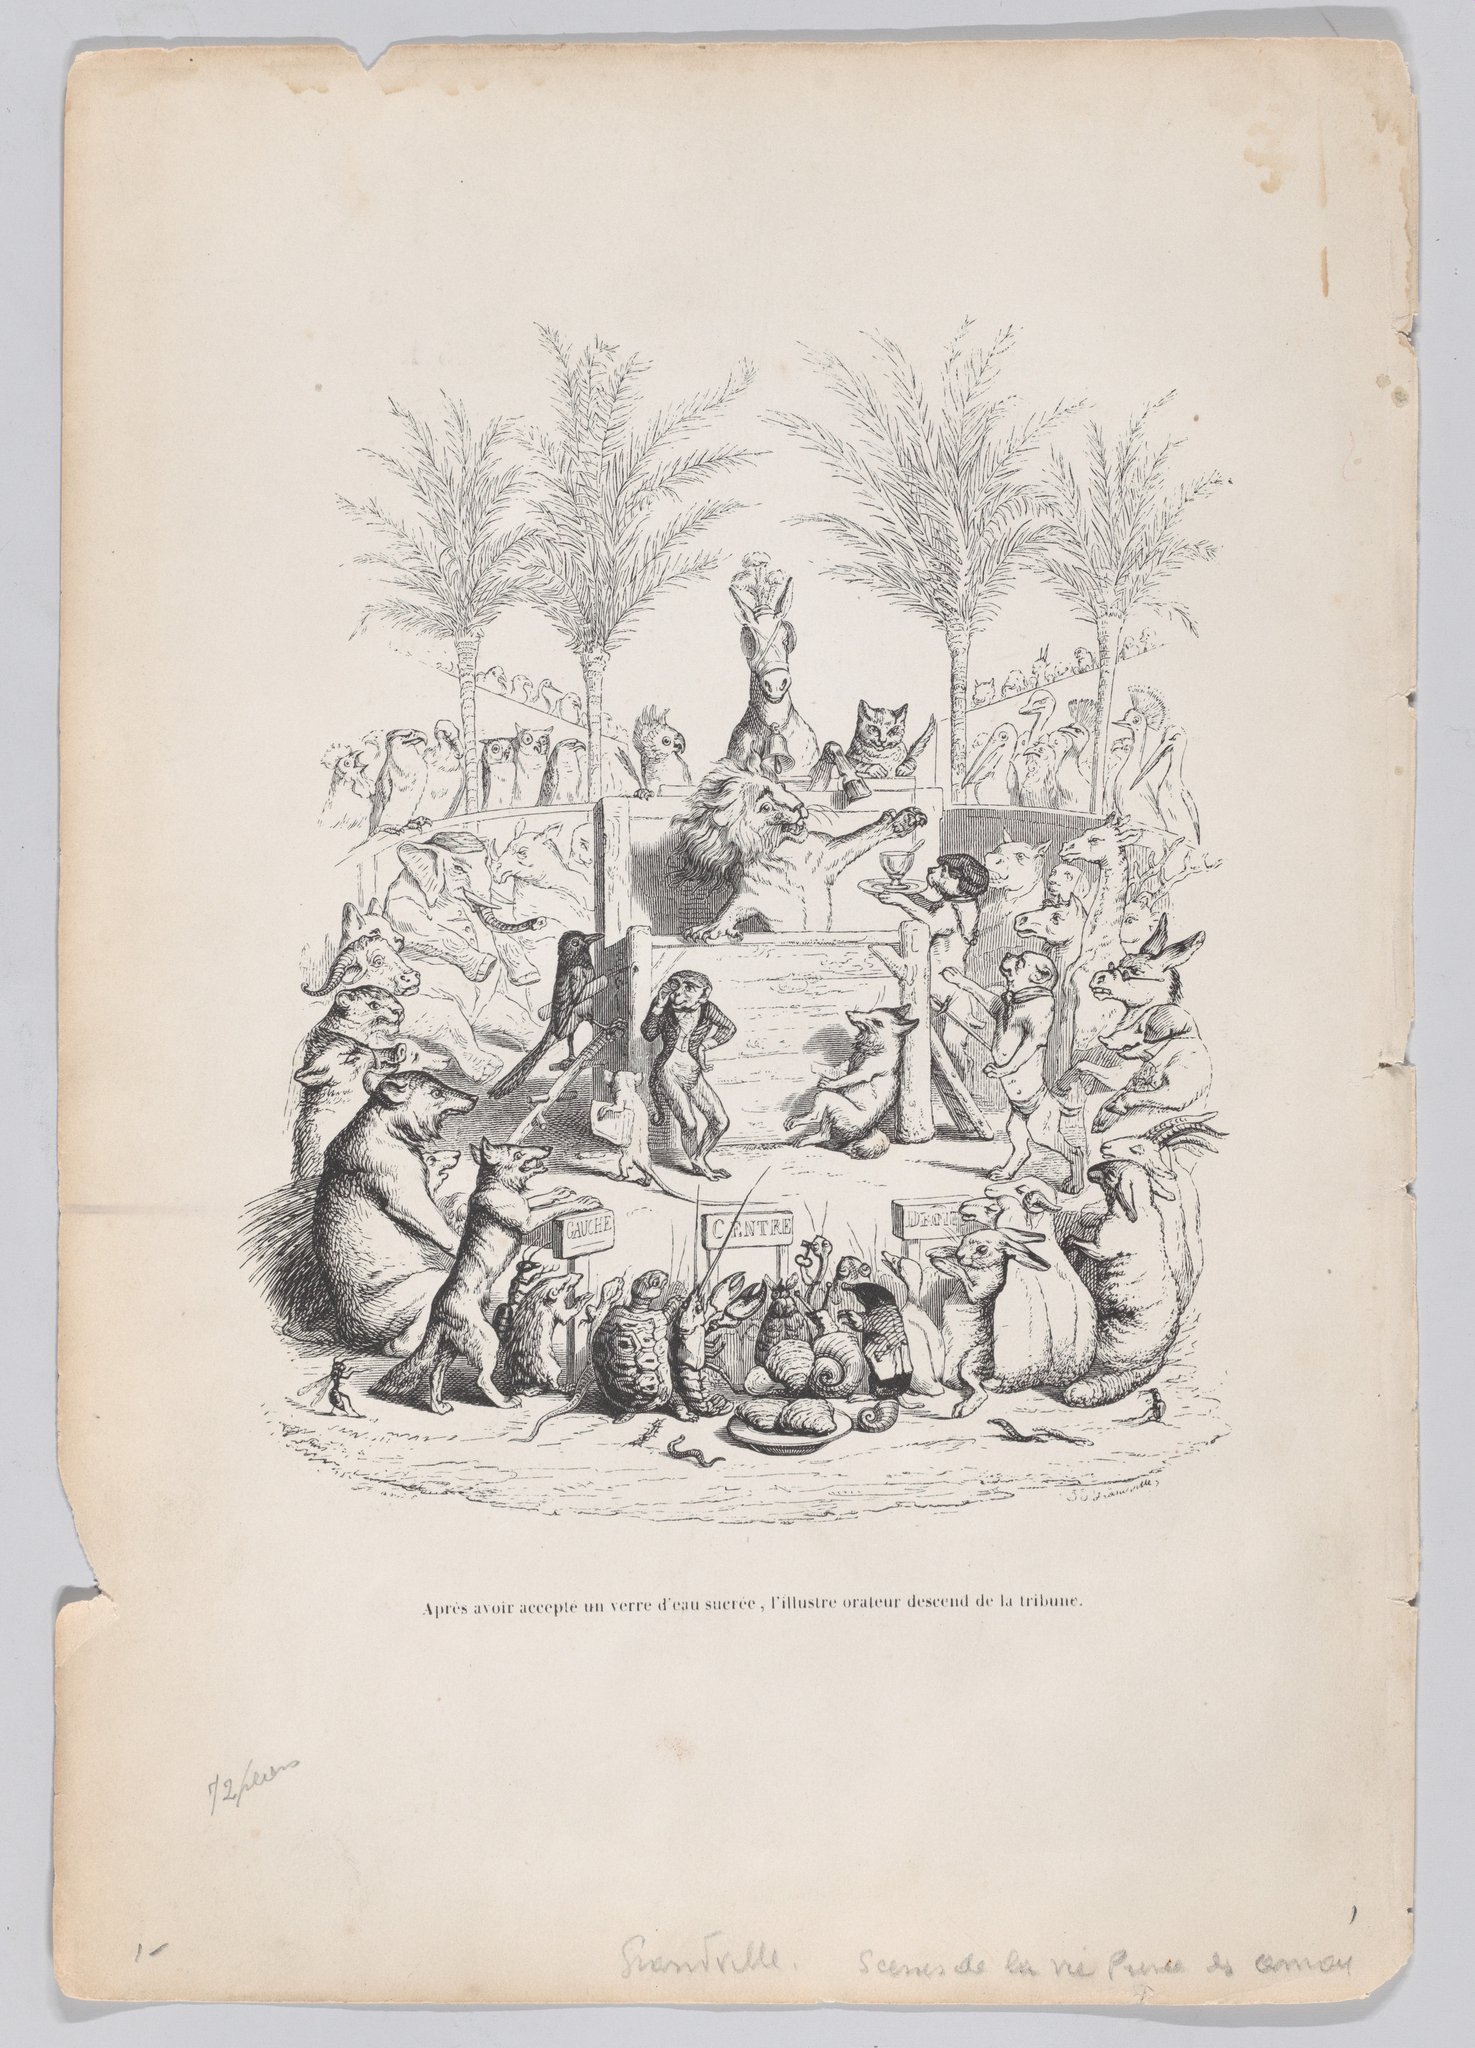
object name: print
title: After accepting a glass of sweet water, the illustrious orator descends from the platform, from "Scenes from the Private and Public Life of Animals"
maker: j. j. grandville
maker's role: artist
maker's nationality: french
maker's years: 1803-1847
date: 1837-1847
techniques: engraving